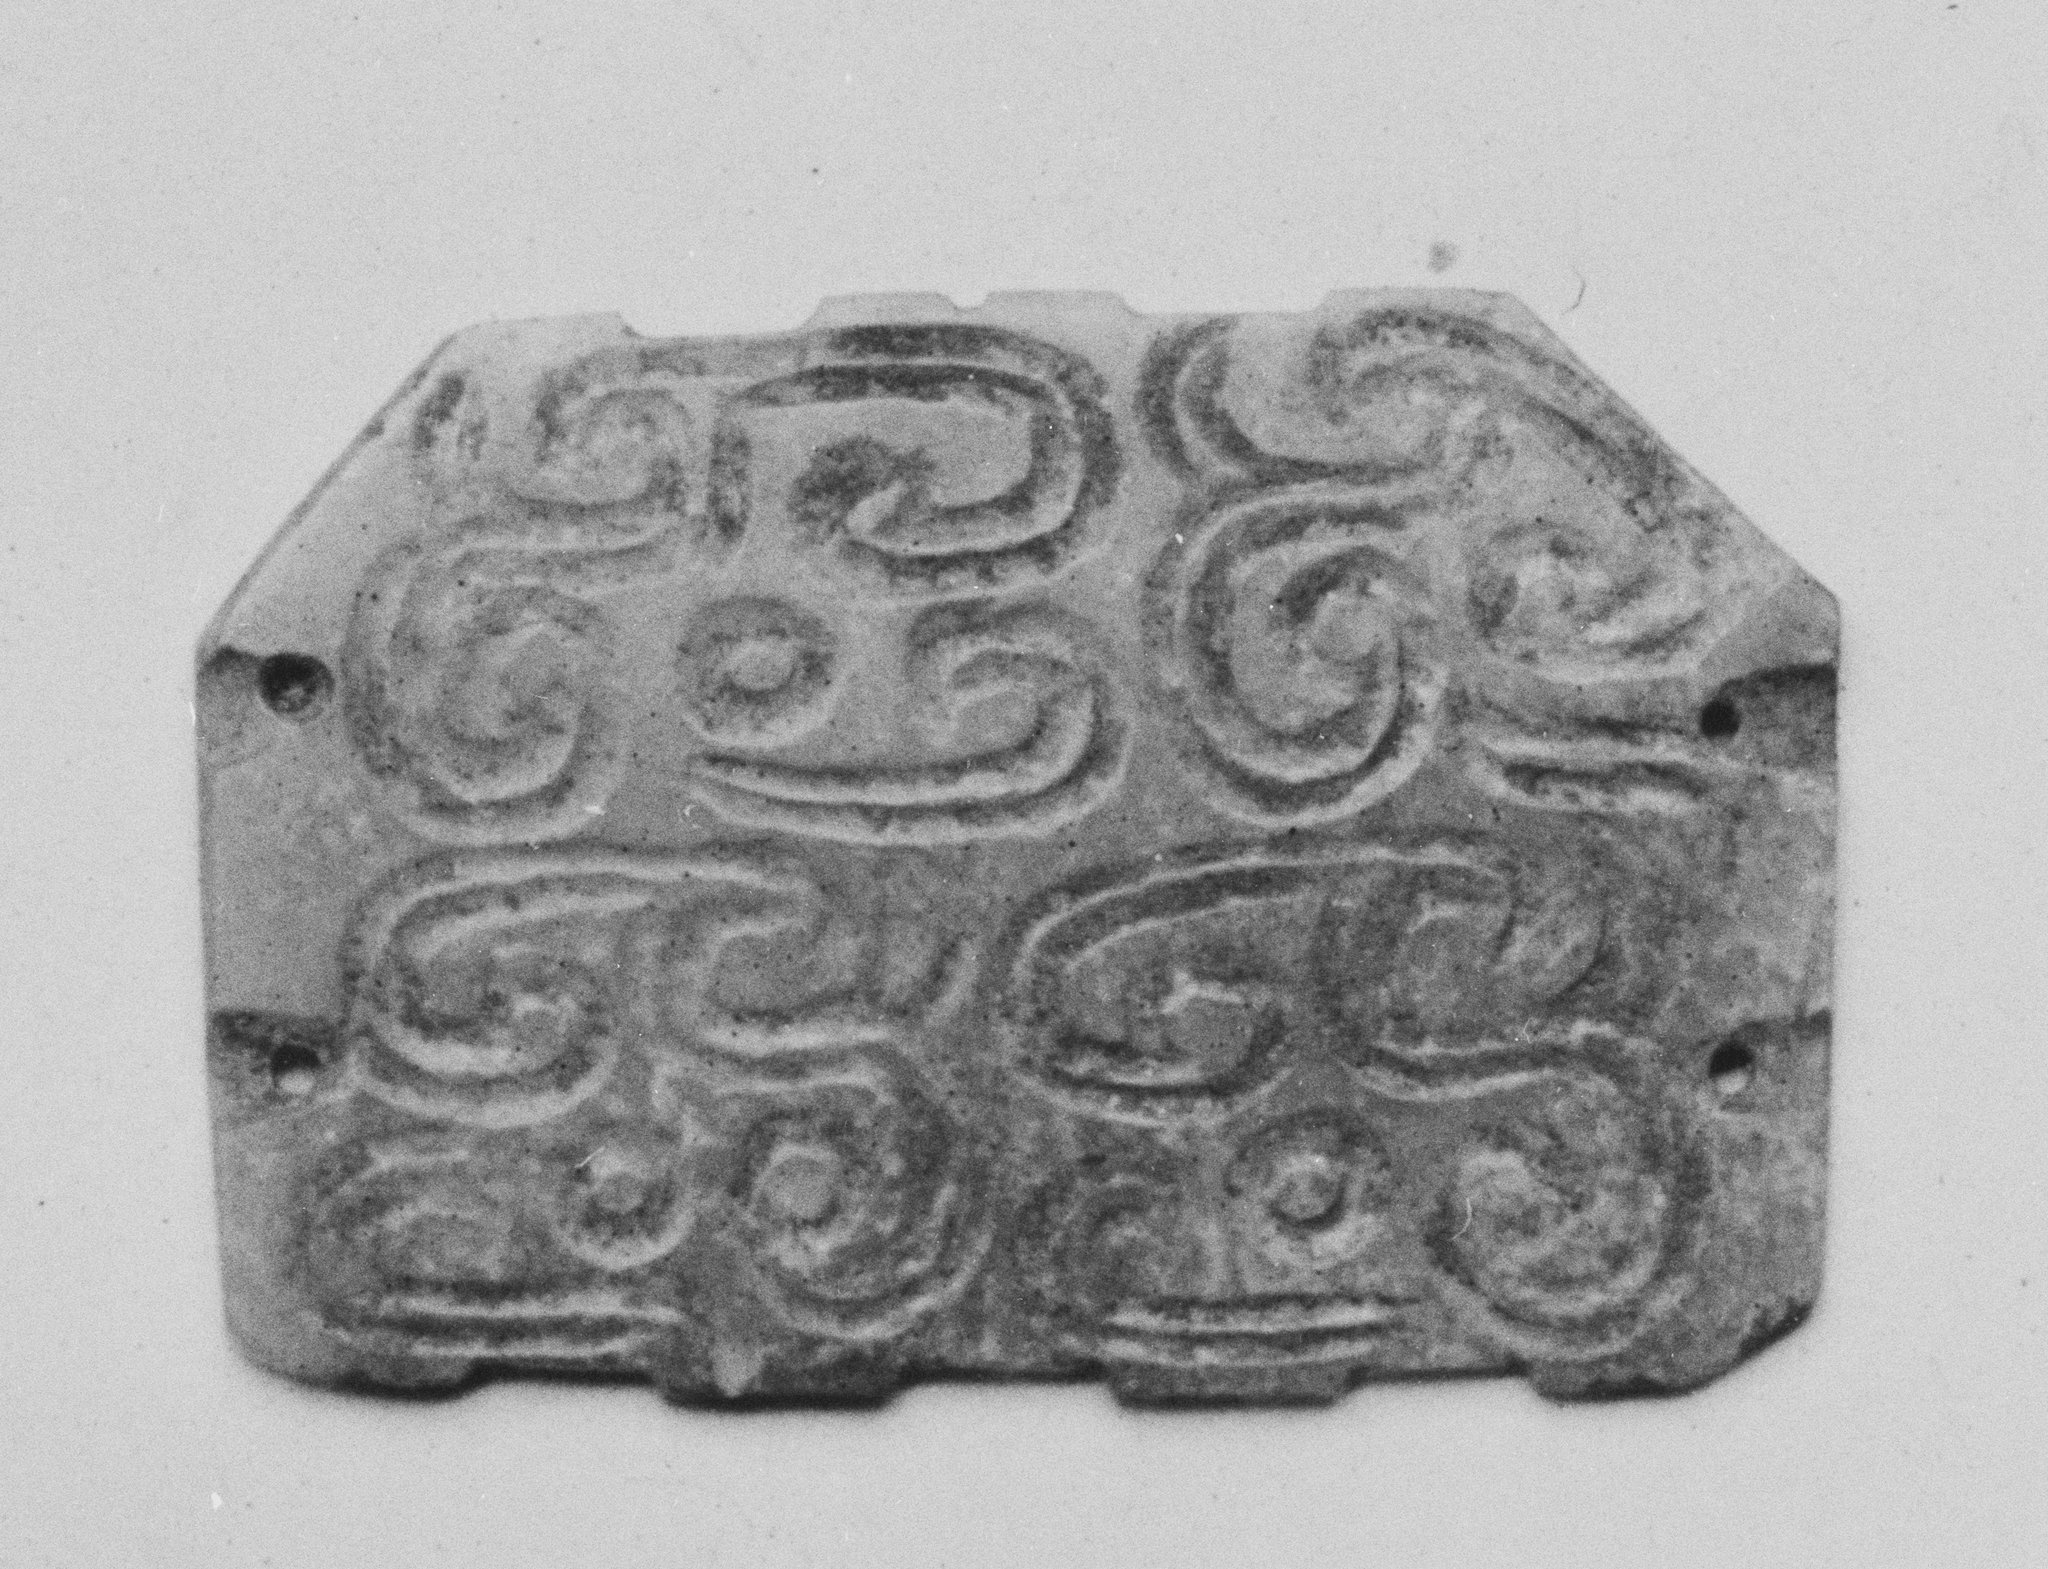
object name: plaque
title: Plaque with decoration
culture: chinese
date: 770-256 BCE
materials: jade